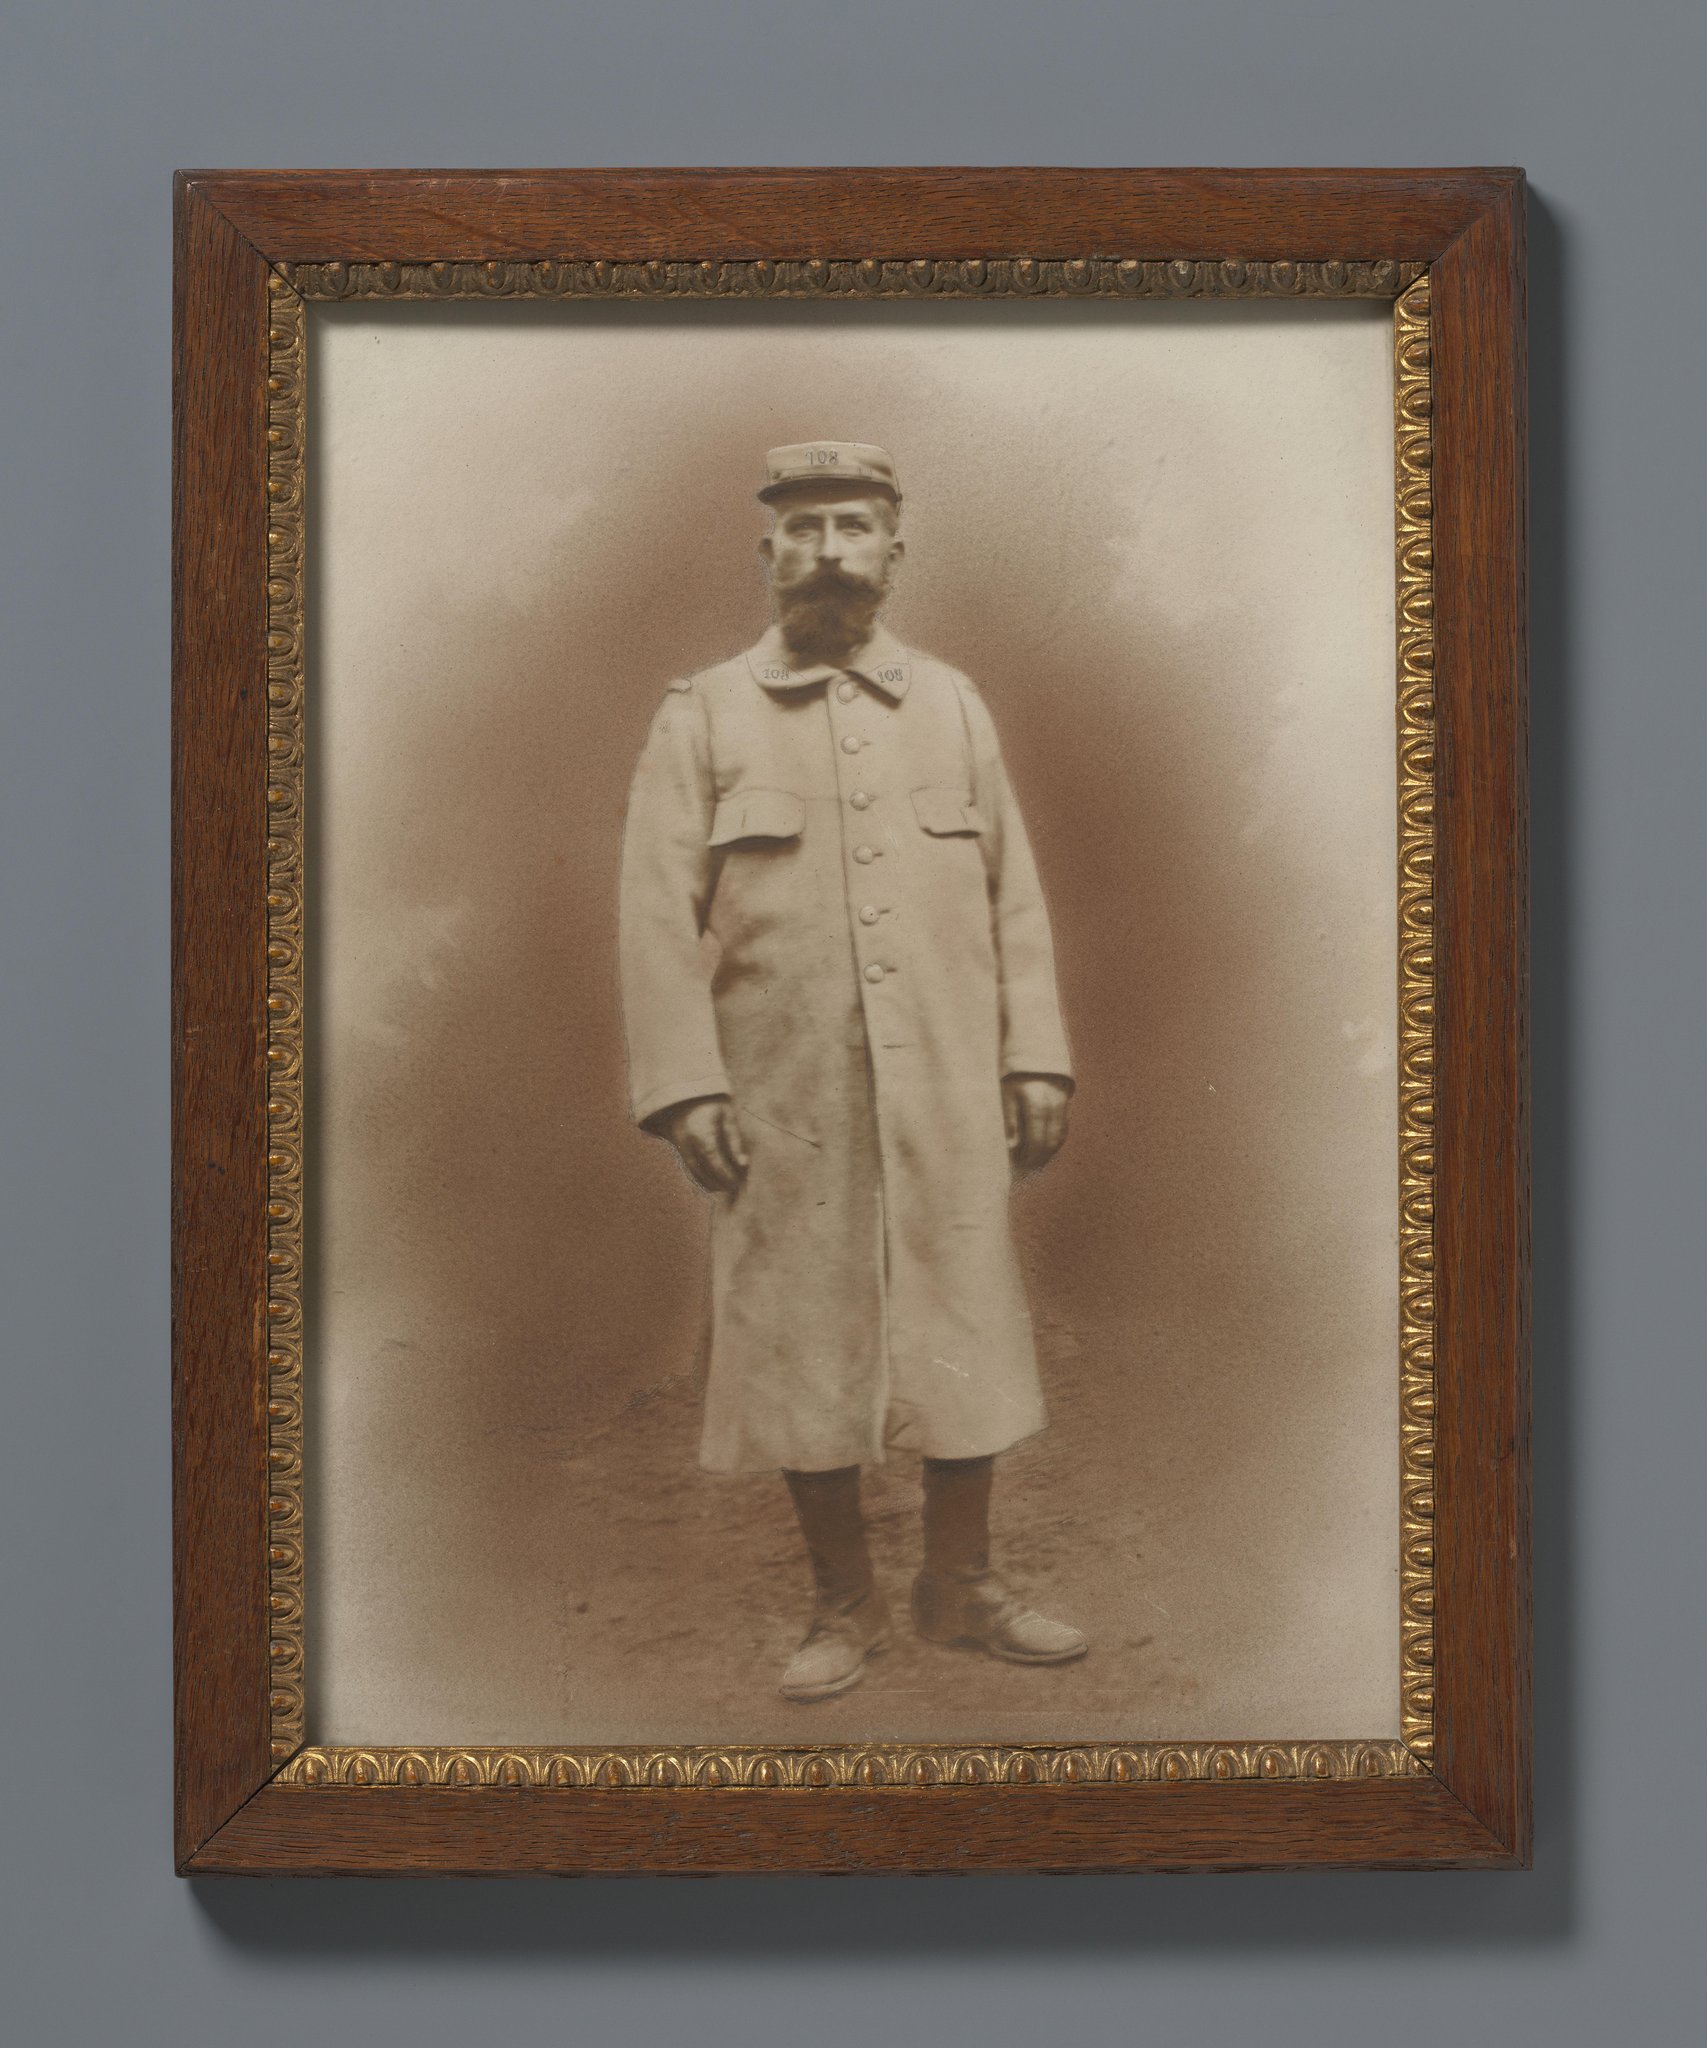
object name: photograph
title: Portret van een onbekende Franse soldaat tijdens de Eerste Wereldoorlog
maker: Anonymous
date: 1914-1918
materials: paper, cardboard, glass, metal, wood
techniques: gelatin silver print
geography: france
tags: (military) uniforms, historical persons not known by name, france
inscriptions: inscription: ‘gekocht vlooienmarkt Parijs/ (rue Jules Vallès)/ juli 1969 NF 10,- (f7.25)’